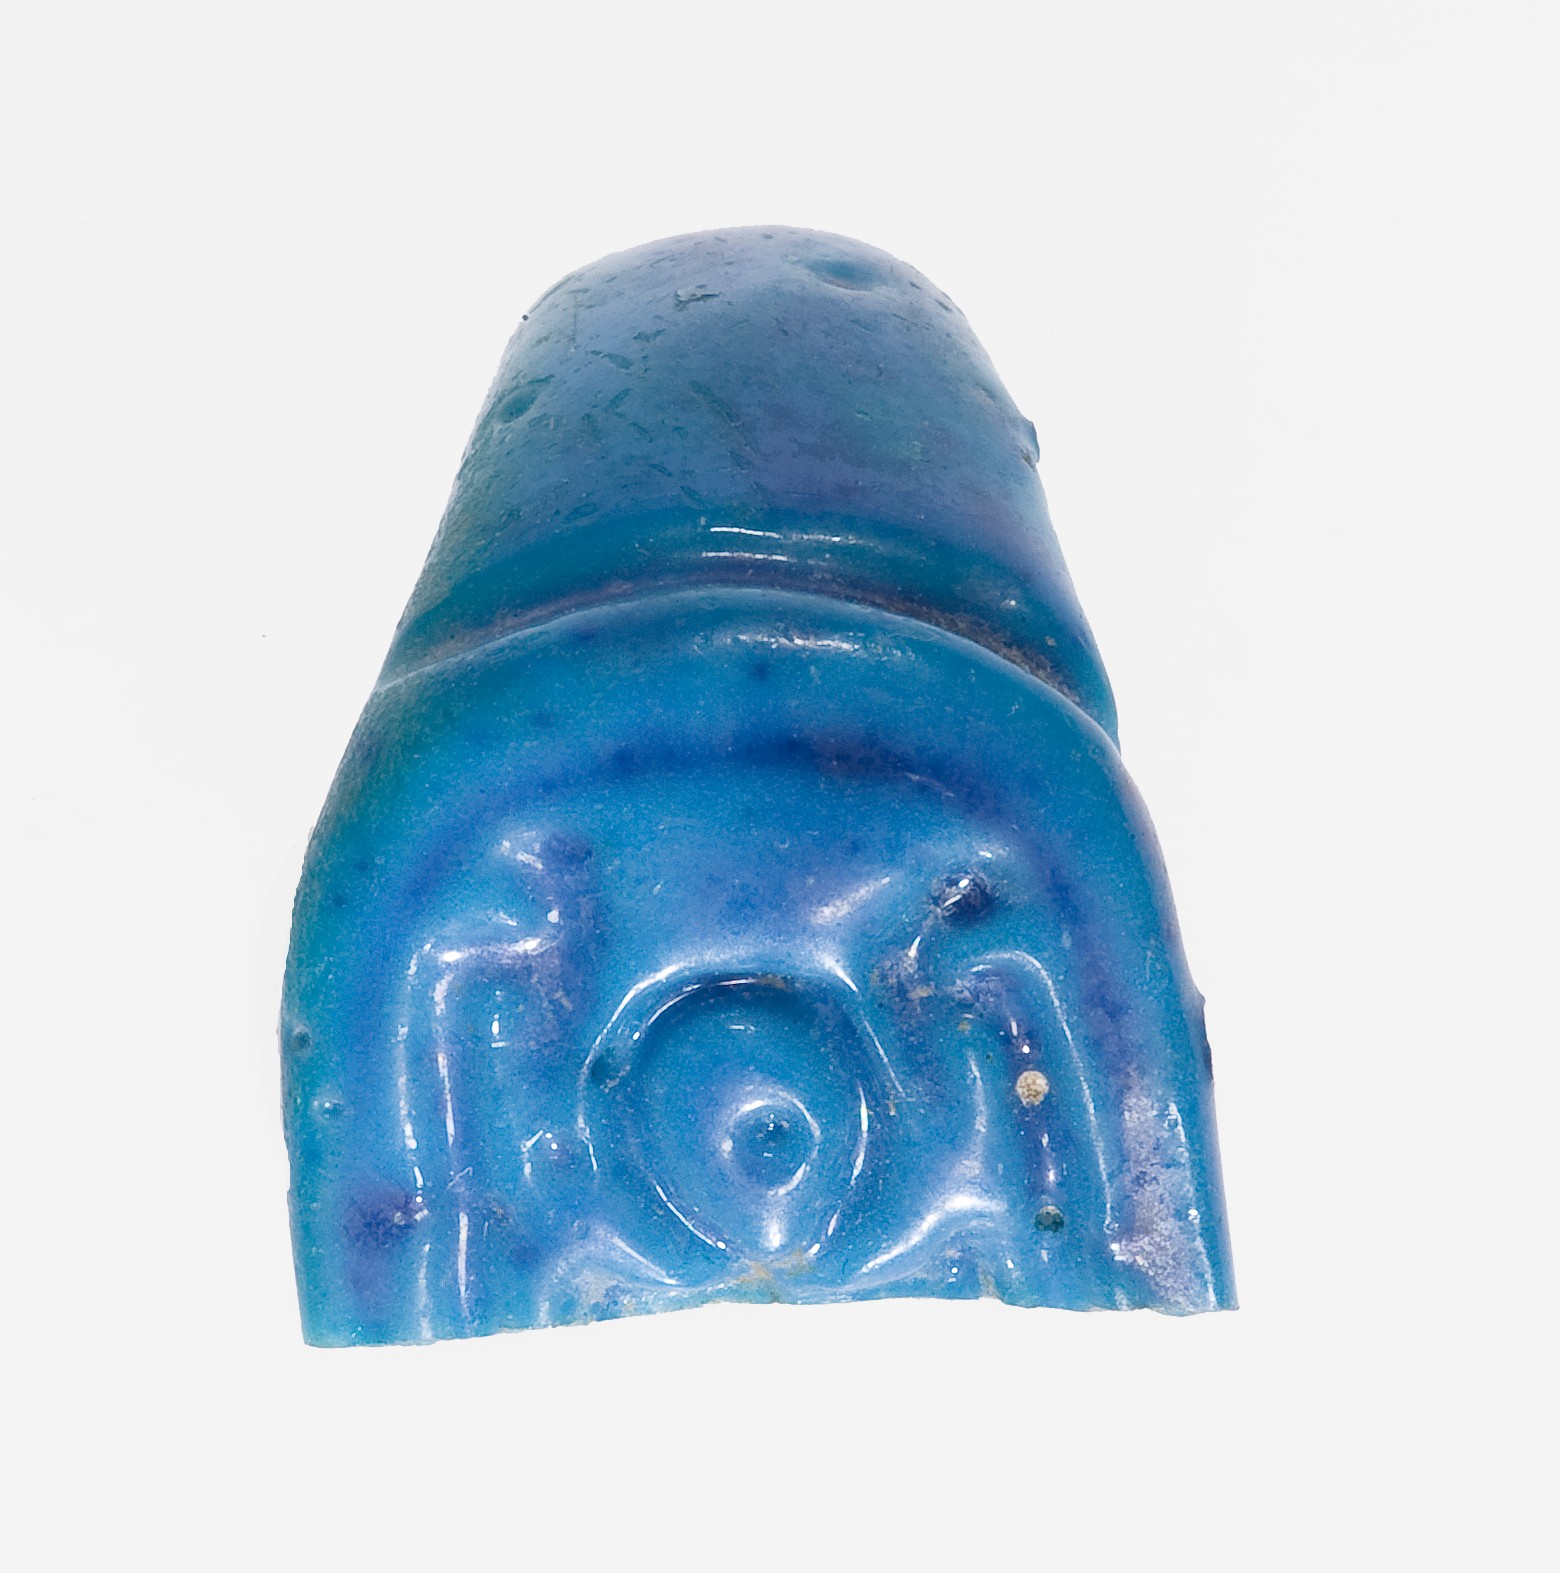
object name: ring fragment, ankh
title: Ring Fragment with Ankh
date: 1390-1352 BCE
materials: faience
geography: egypt